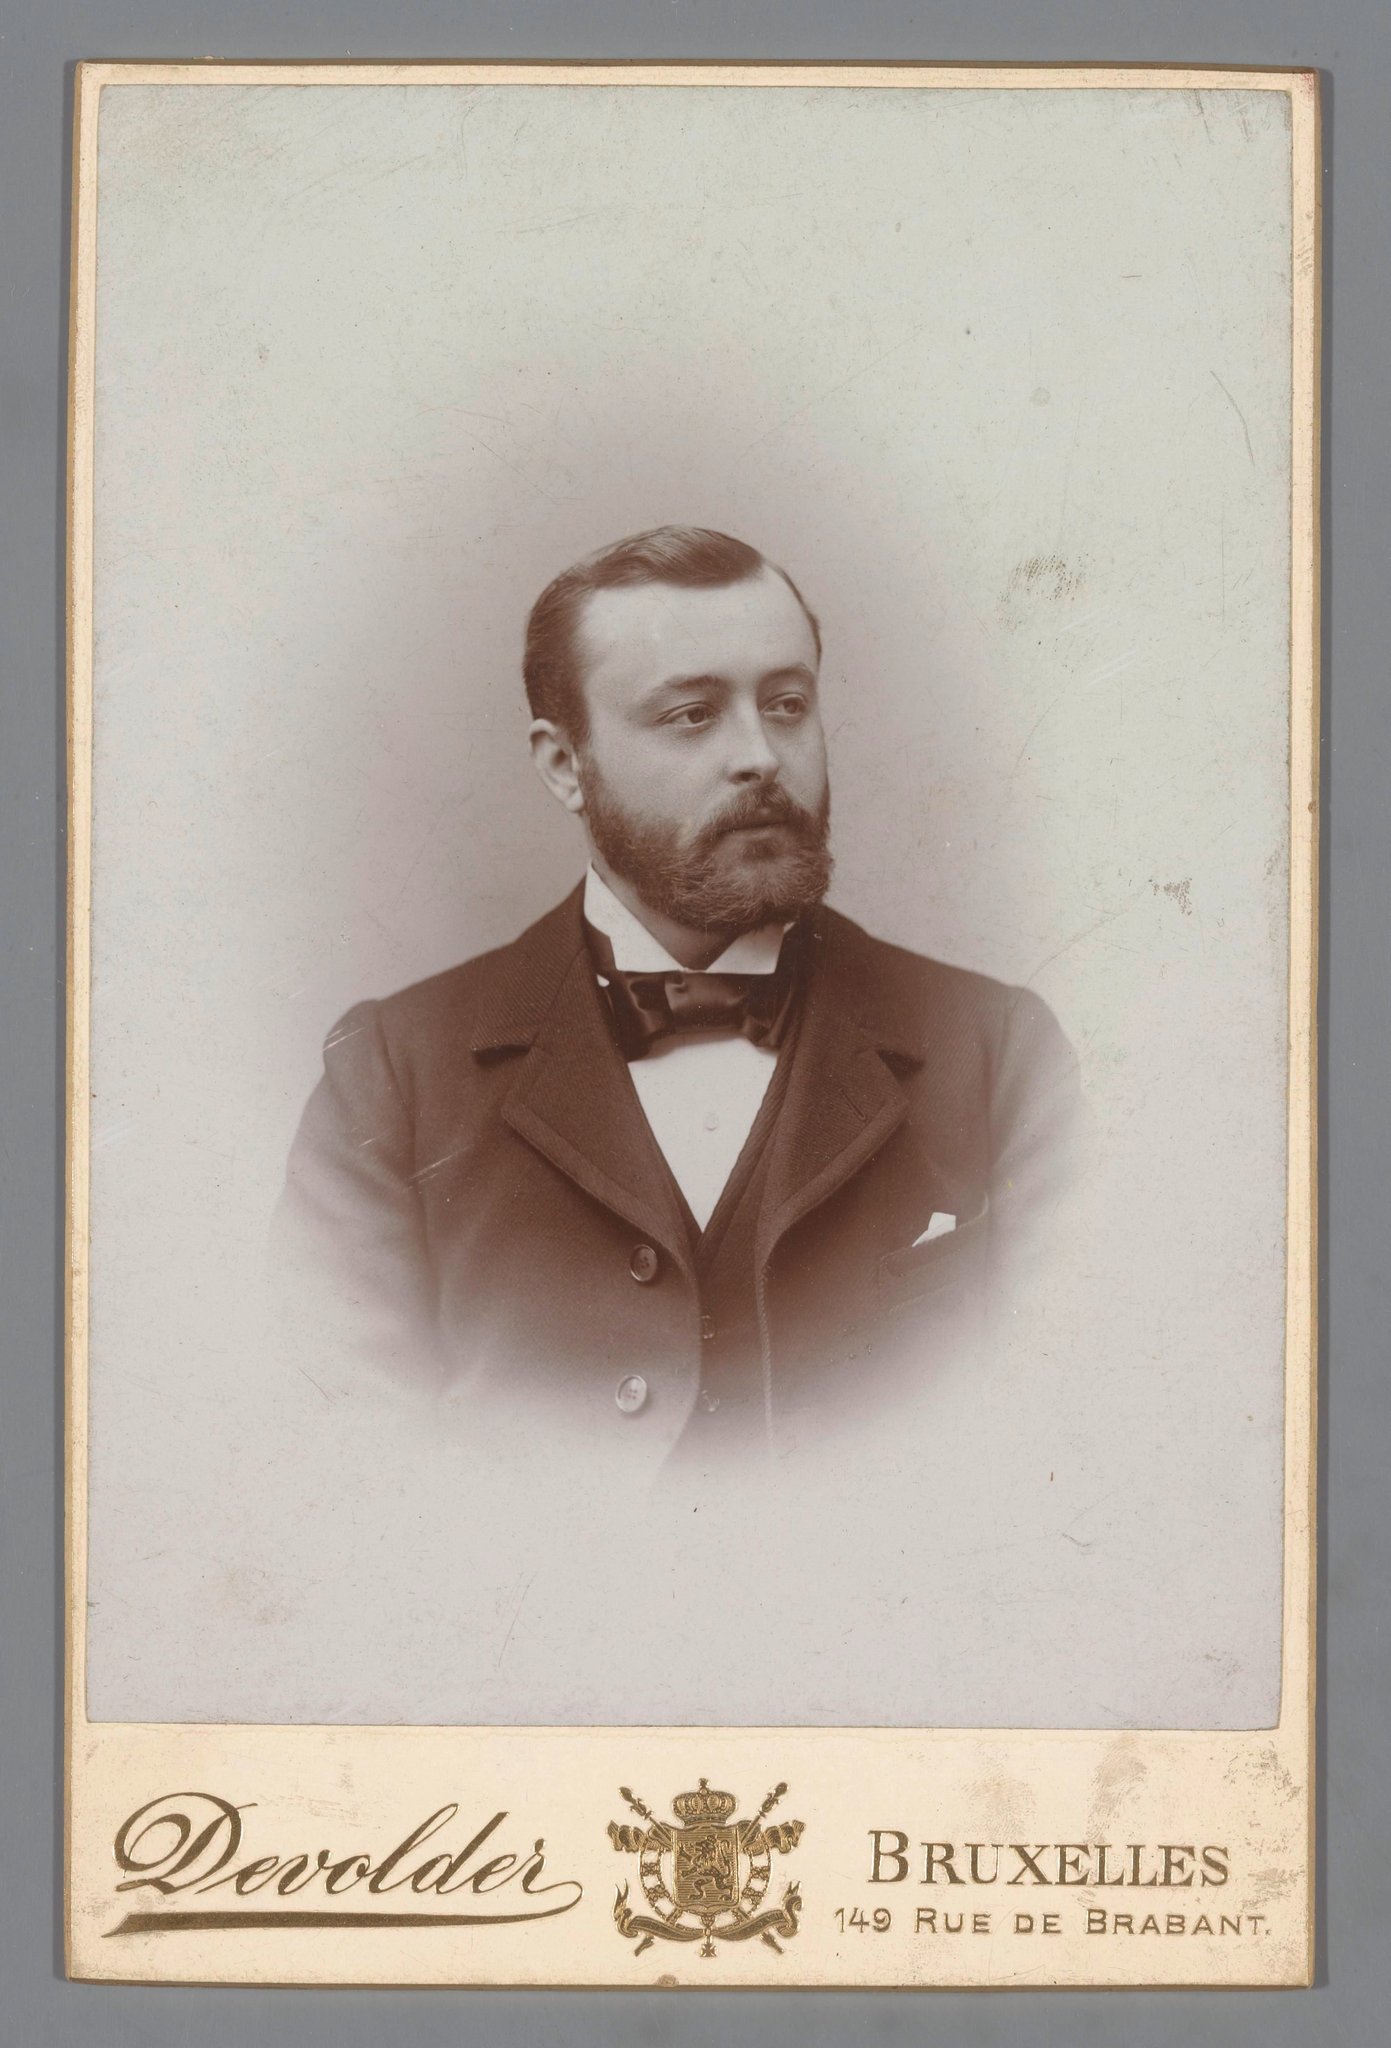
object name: cabinet photograph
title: Portret van een onbekende man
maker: louis devolder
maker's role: fotograaf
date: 1900-1920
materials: cardboard, photographic support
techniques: collodion silver print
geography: brussels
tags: adult man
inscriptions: name: ‘Photographie L. Devolder 149. Rue de Brabant Bruxelles Succursale à Reims 27-29 rue Carnot ancienne rue des Tapissiers. Les clichés sont conservés.’